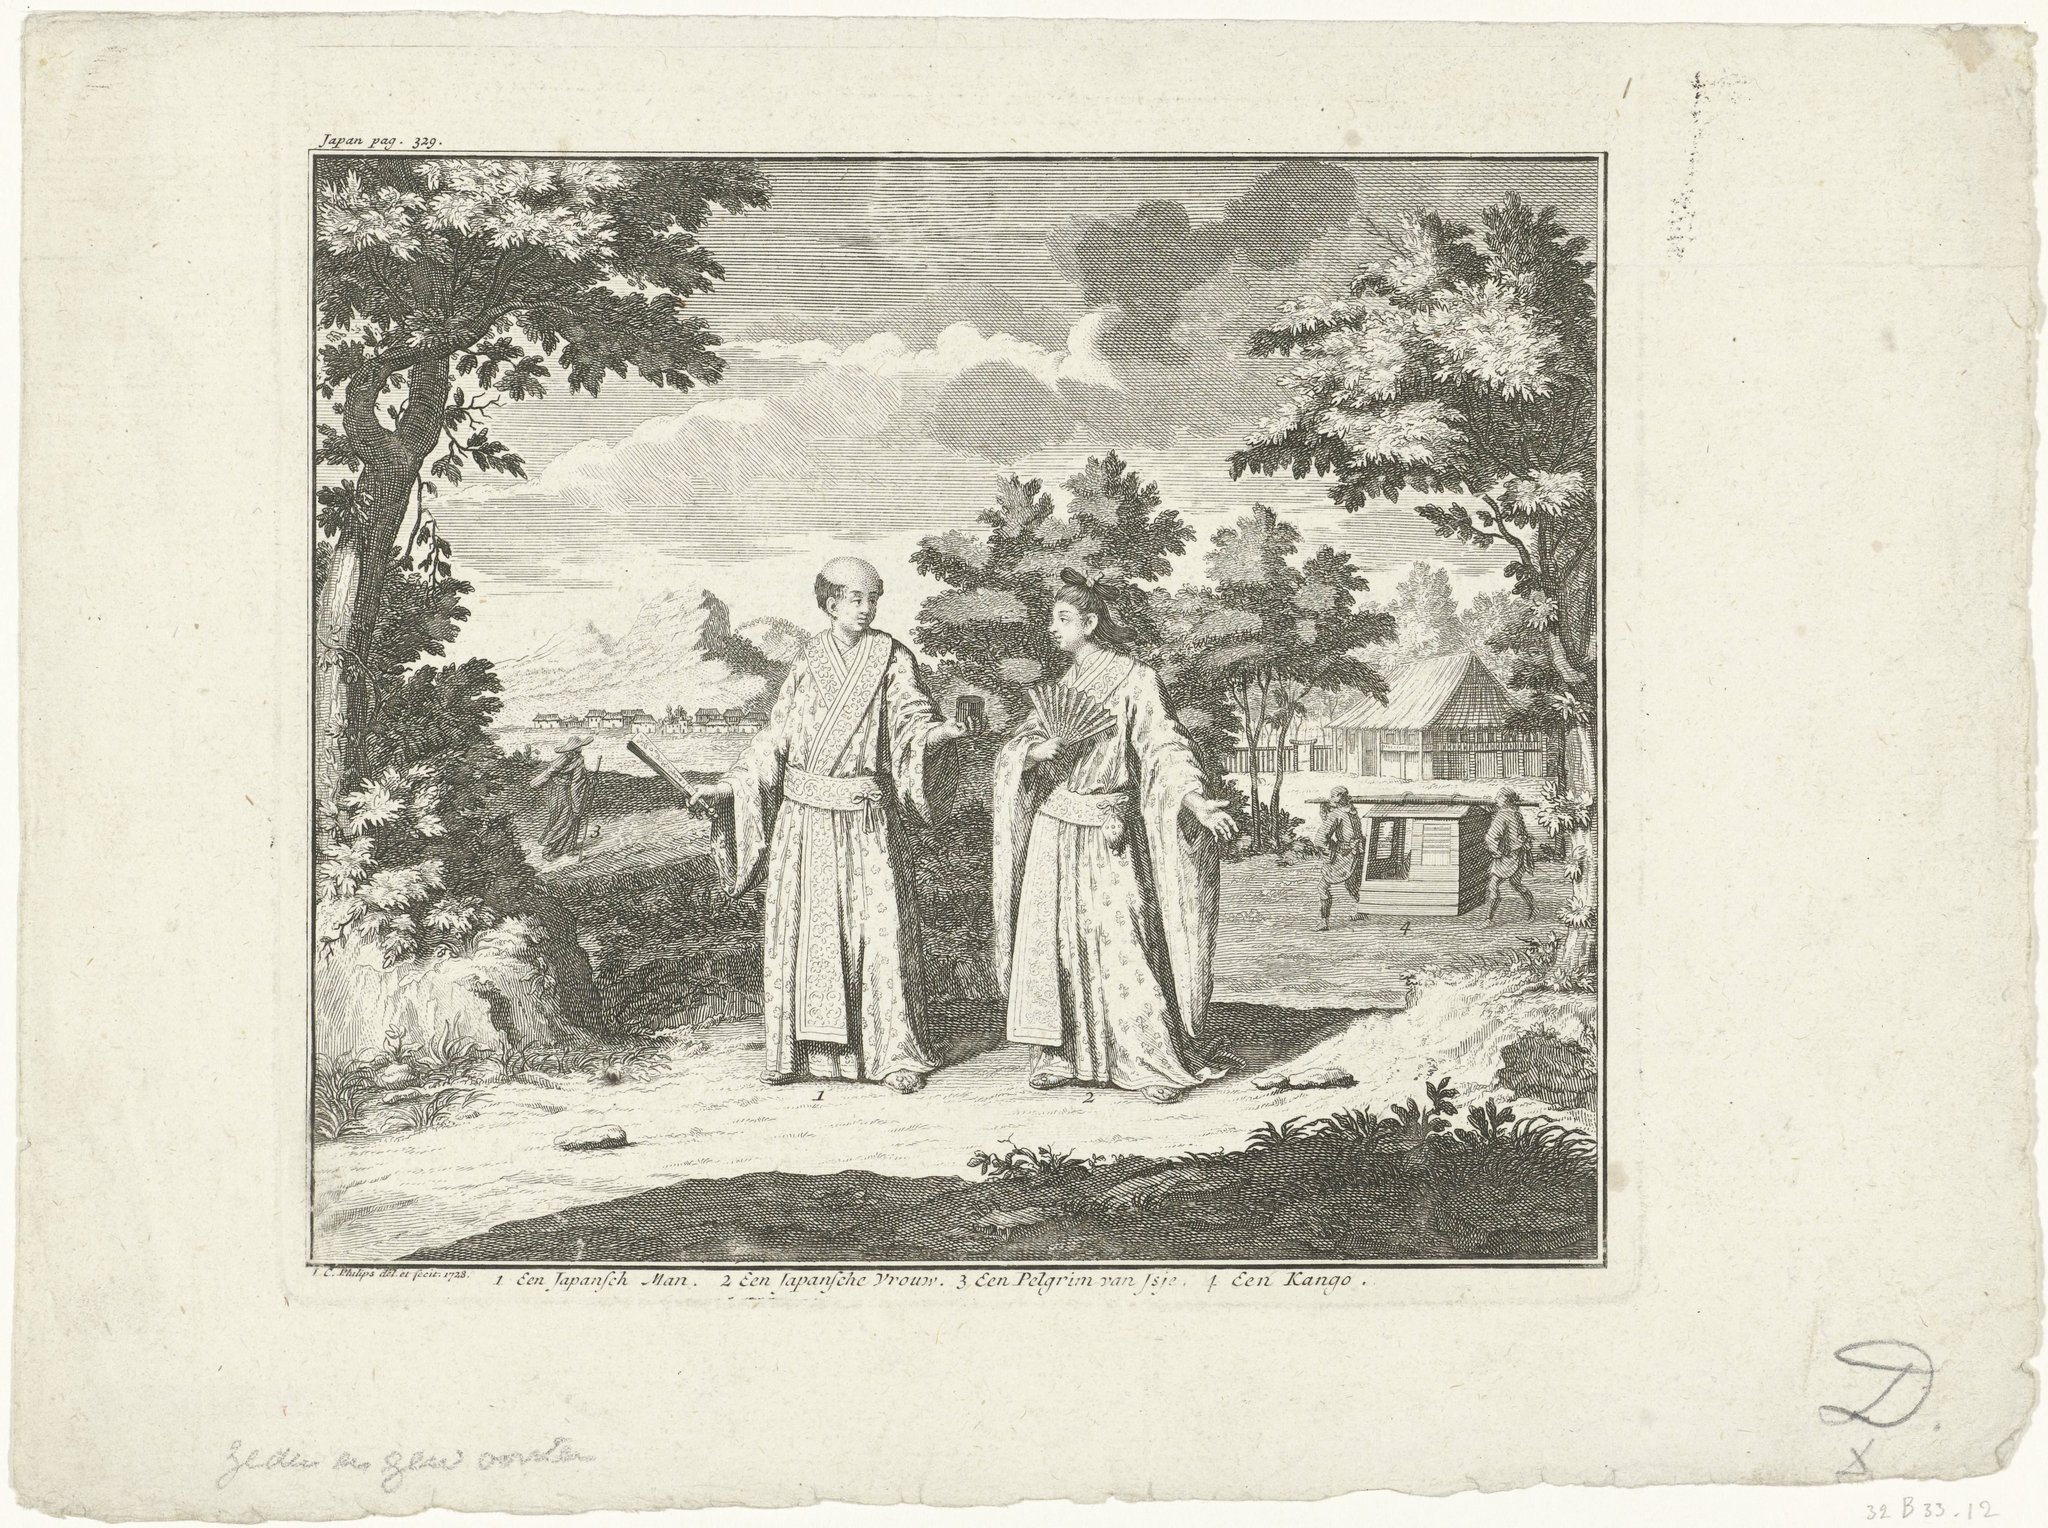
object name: book illustration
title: Landschap met een Japans paar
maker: jan caspar philips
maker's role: draughtsman, print maker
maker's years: 1700-1775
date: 1728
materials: paper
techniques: etching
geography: amsterdam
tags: rickshaw, japanese, 'en route', traveller under way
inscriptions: number: ‘1’, collector's mark: Lugt 2233, collector's mark: Lugt 2228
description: Illustratie uit: Salmon, Thomas.Hedendaegsche historie, of Tegenwoordige staet van alle volkeren (...). I. deel. Behelzende de (...) keizerryken China en Japan. [Vertaald uit het Engels door] M. van Goch. Amsterdam: Isaak Tirion, 1728. Zeden en gewoonten